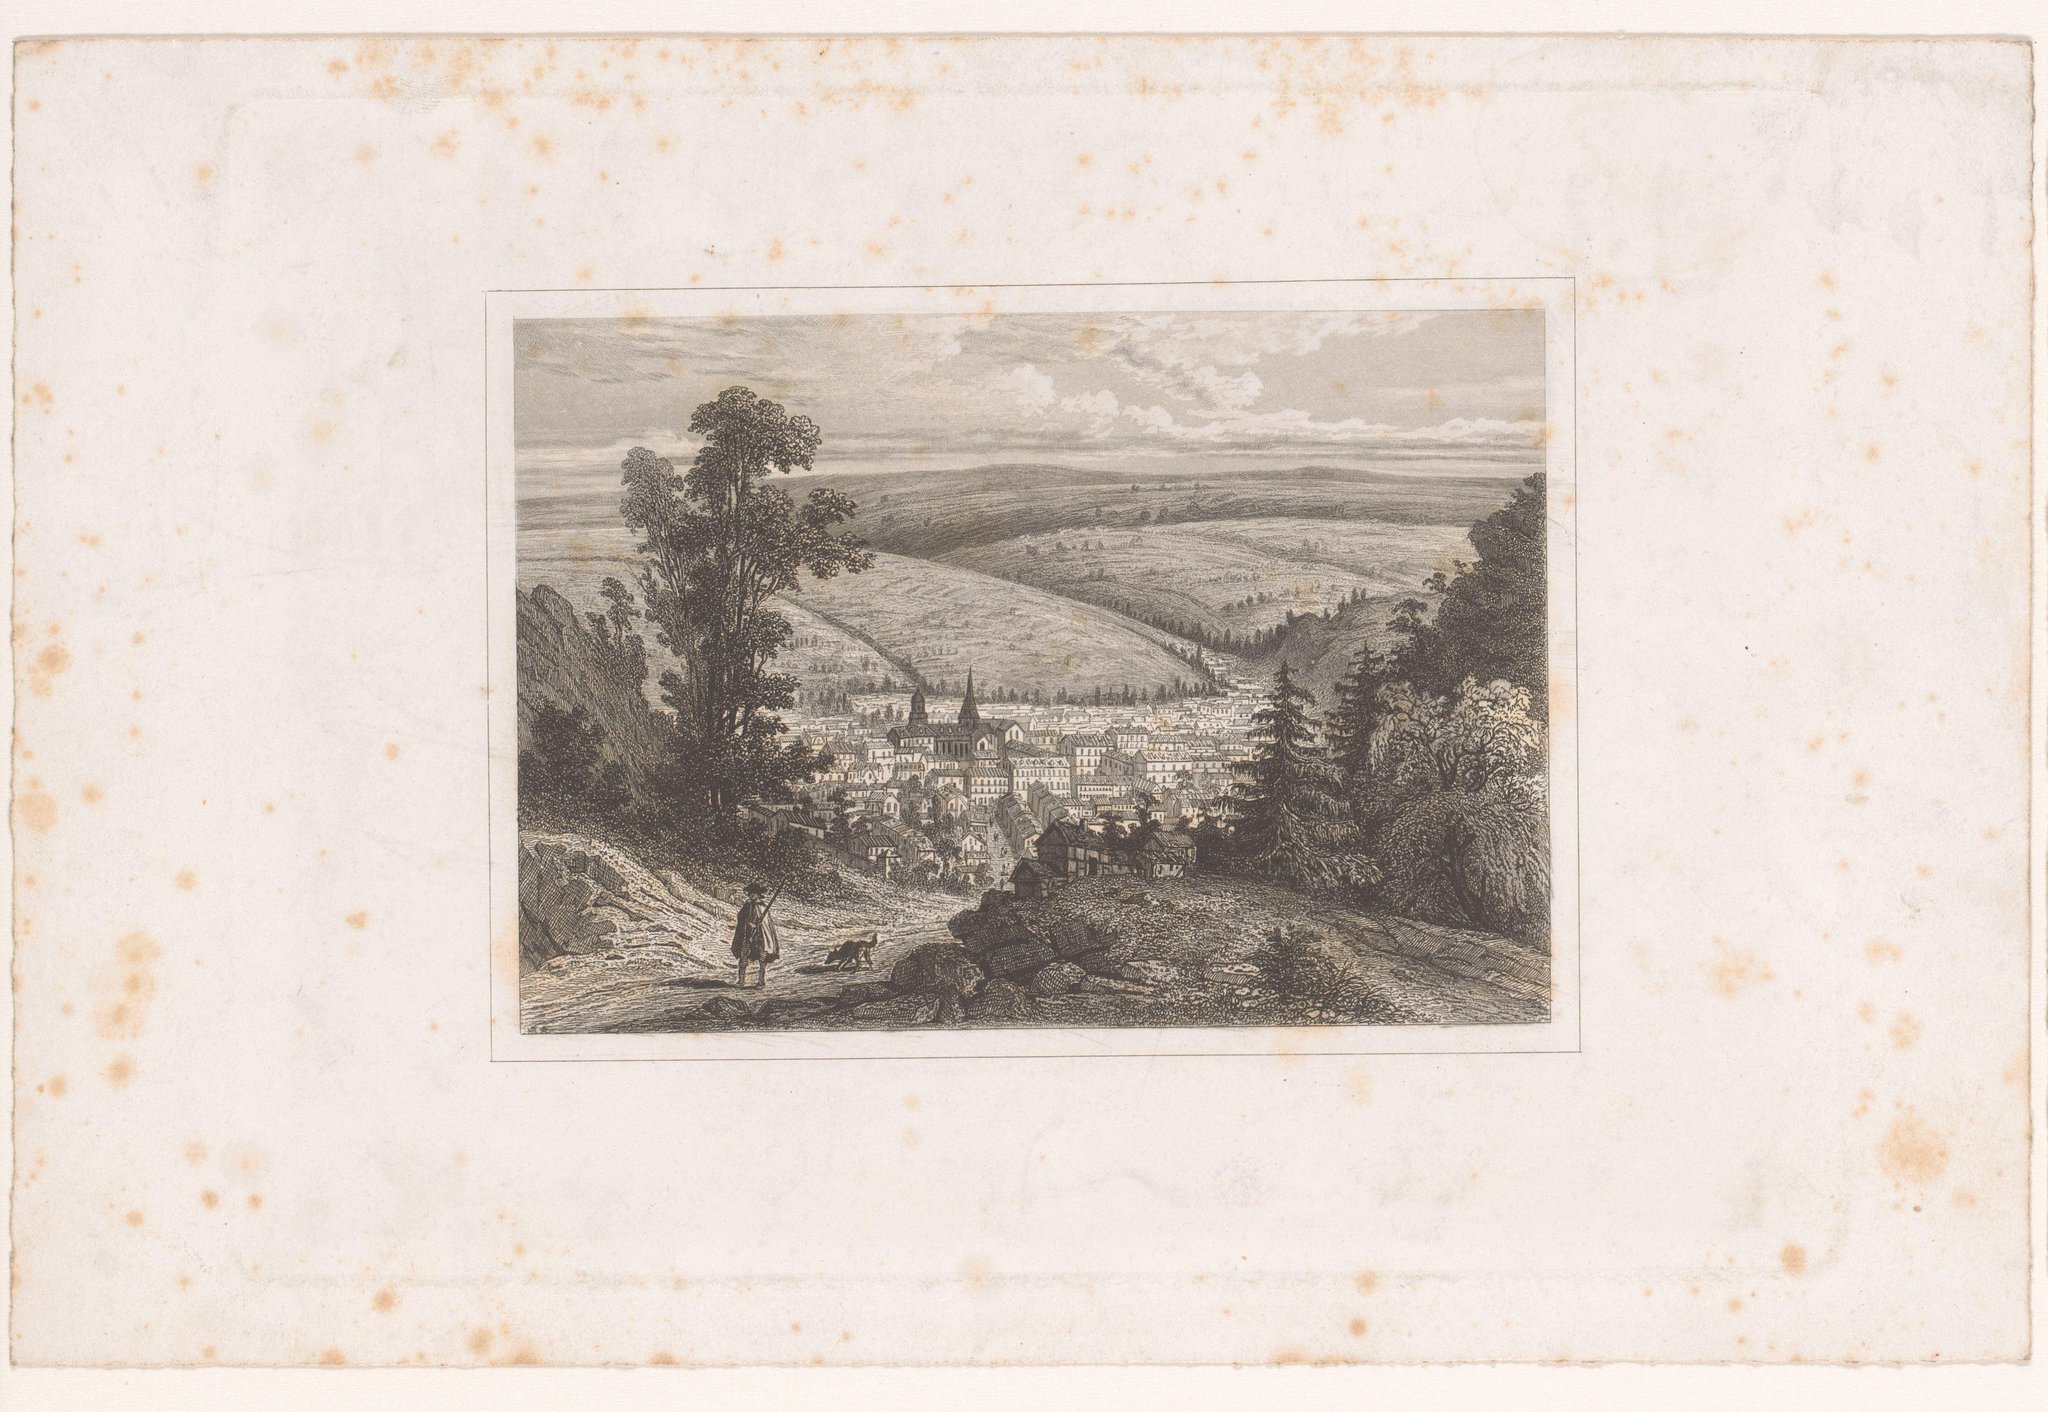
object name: print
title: Heuvellandschap met stad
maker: auguste numans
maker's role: print maker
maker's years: 1823-1883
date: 1833-1880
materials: paper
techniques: etching, roulette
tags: low hill country, church (exterior), city-view in general; 'veduta' (+ city(-scape) with figures, staffage)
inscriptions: collector's mark: Lugt 2228